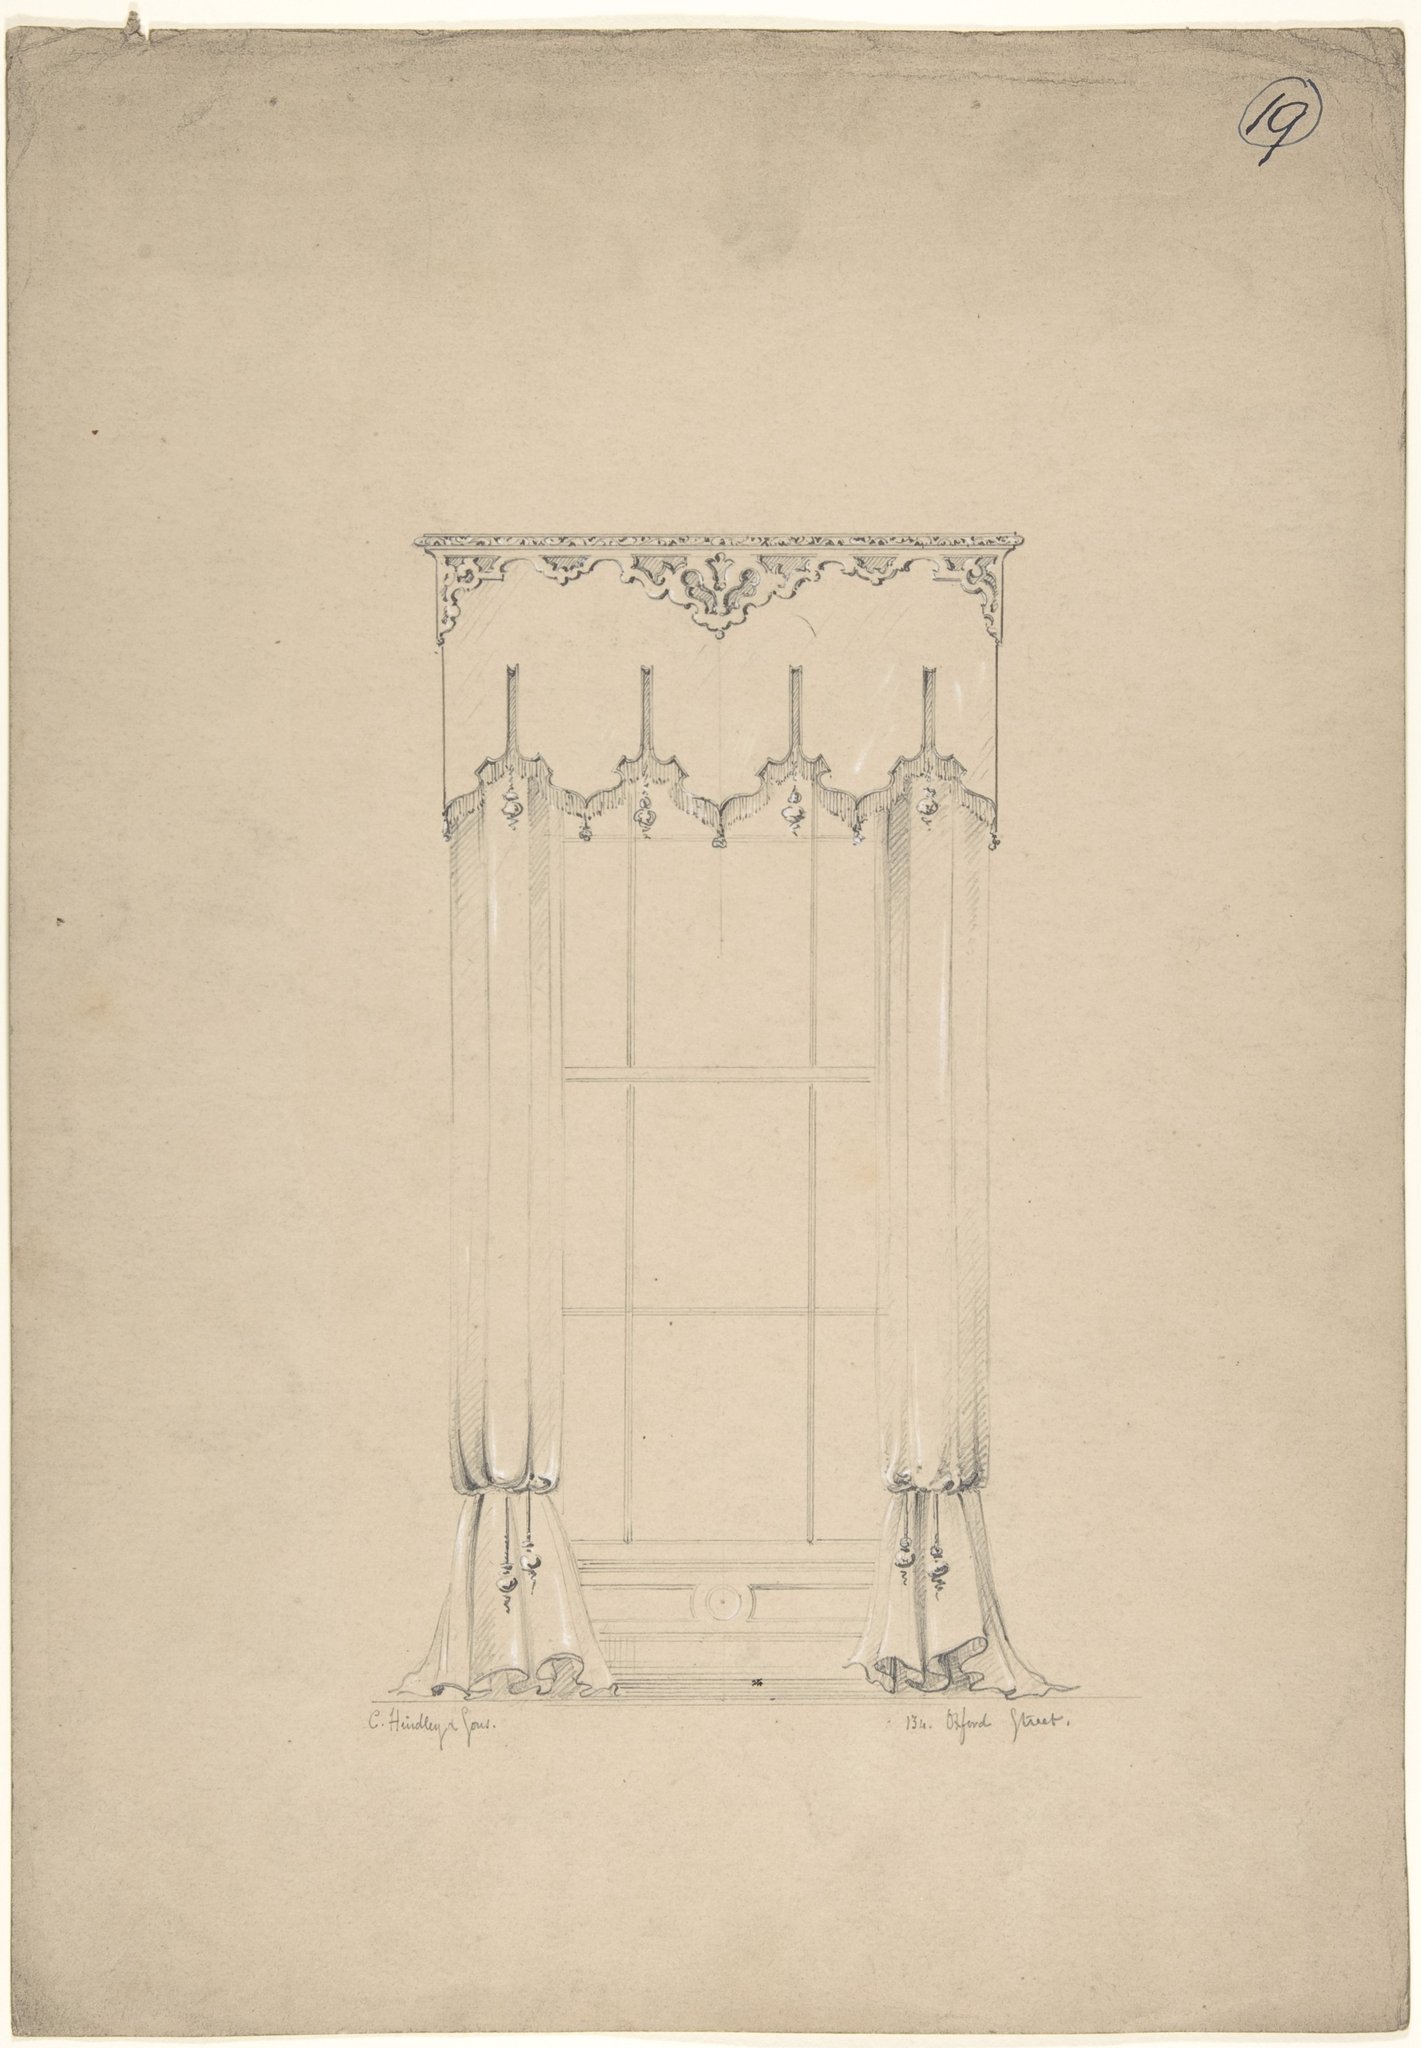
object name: drawing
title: Design for Curtains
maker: charles hindley and sons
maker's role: artist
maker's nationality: british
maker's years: 1841-1917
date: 1841-1884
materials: gouache, graphite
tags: curtains